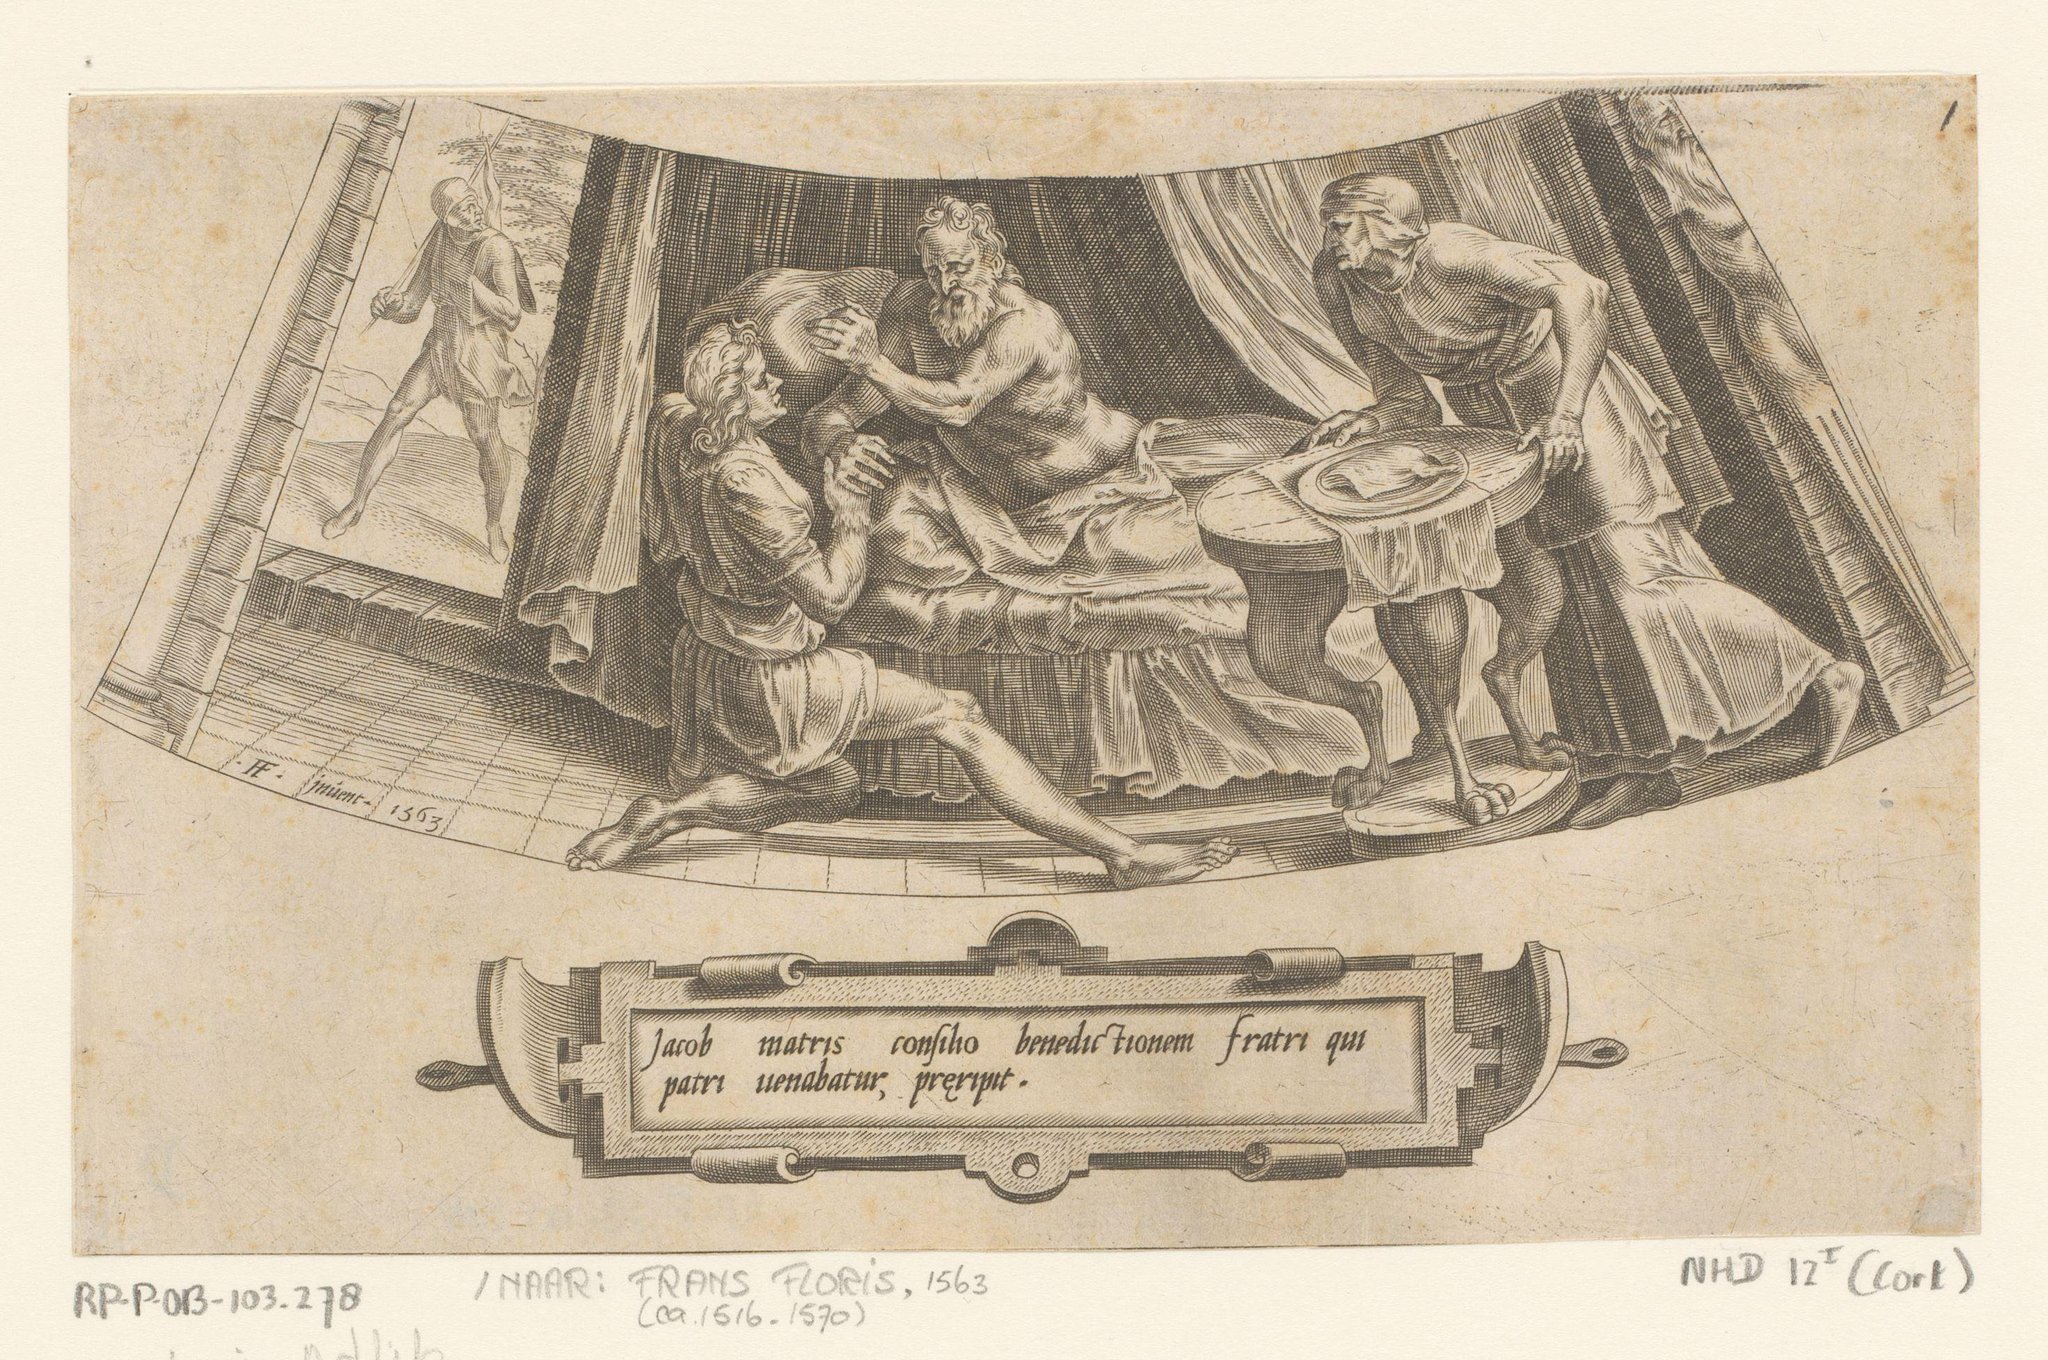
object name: print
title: Geschiedenis van Jakob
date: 1563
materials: paper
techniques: engraving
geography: antwerp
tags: isaac lying in bed blesses jacob who, disguised in esau's clothes, brings food to his father; jacob's hands and neck are covered with goatskins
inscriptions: collector's mark: Lugt 2228, collector's mark: ‘[AP]’